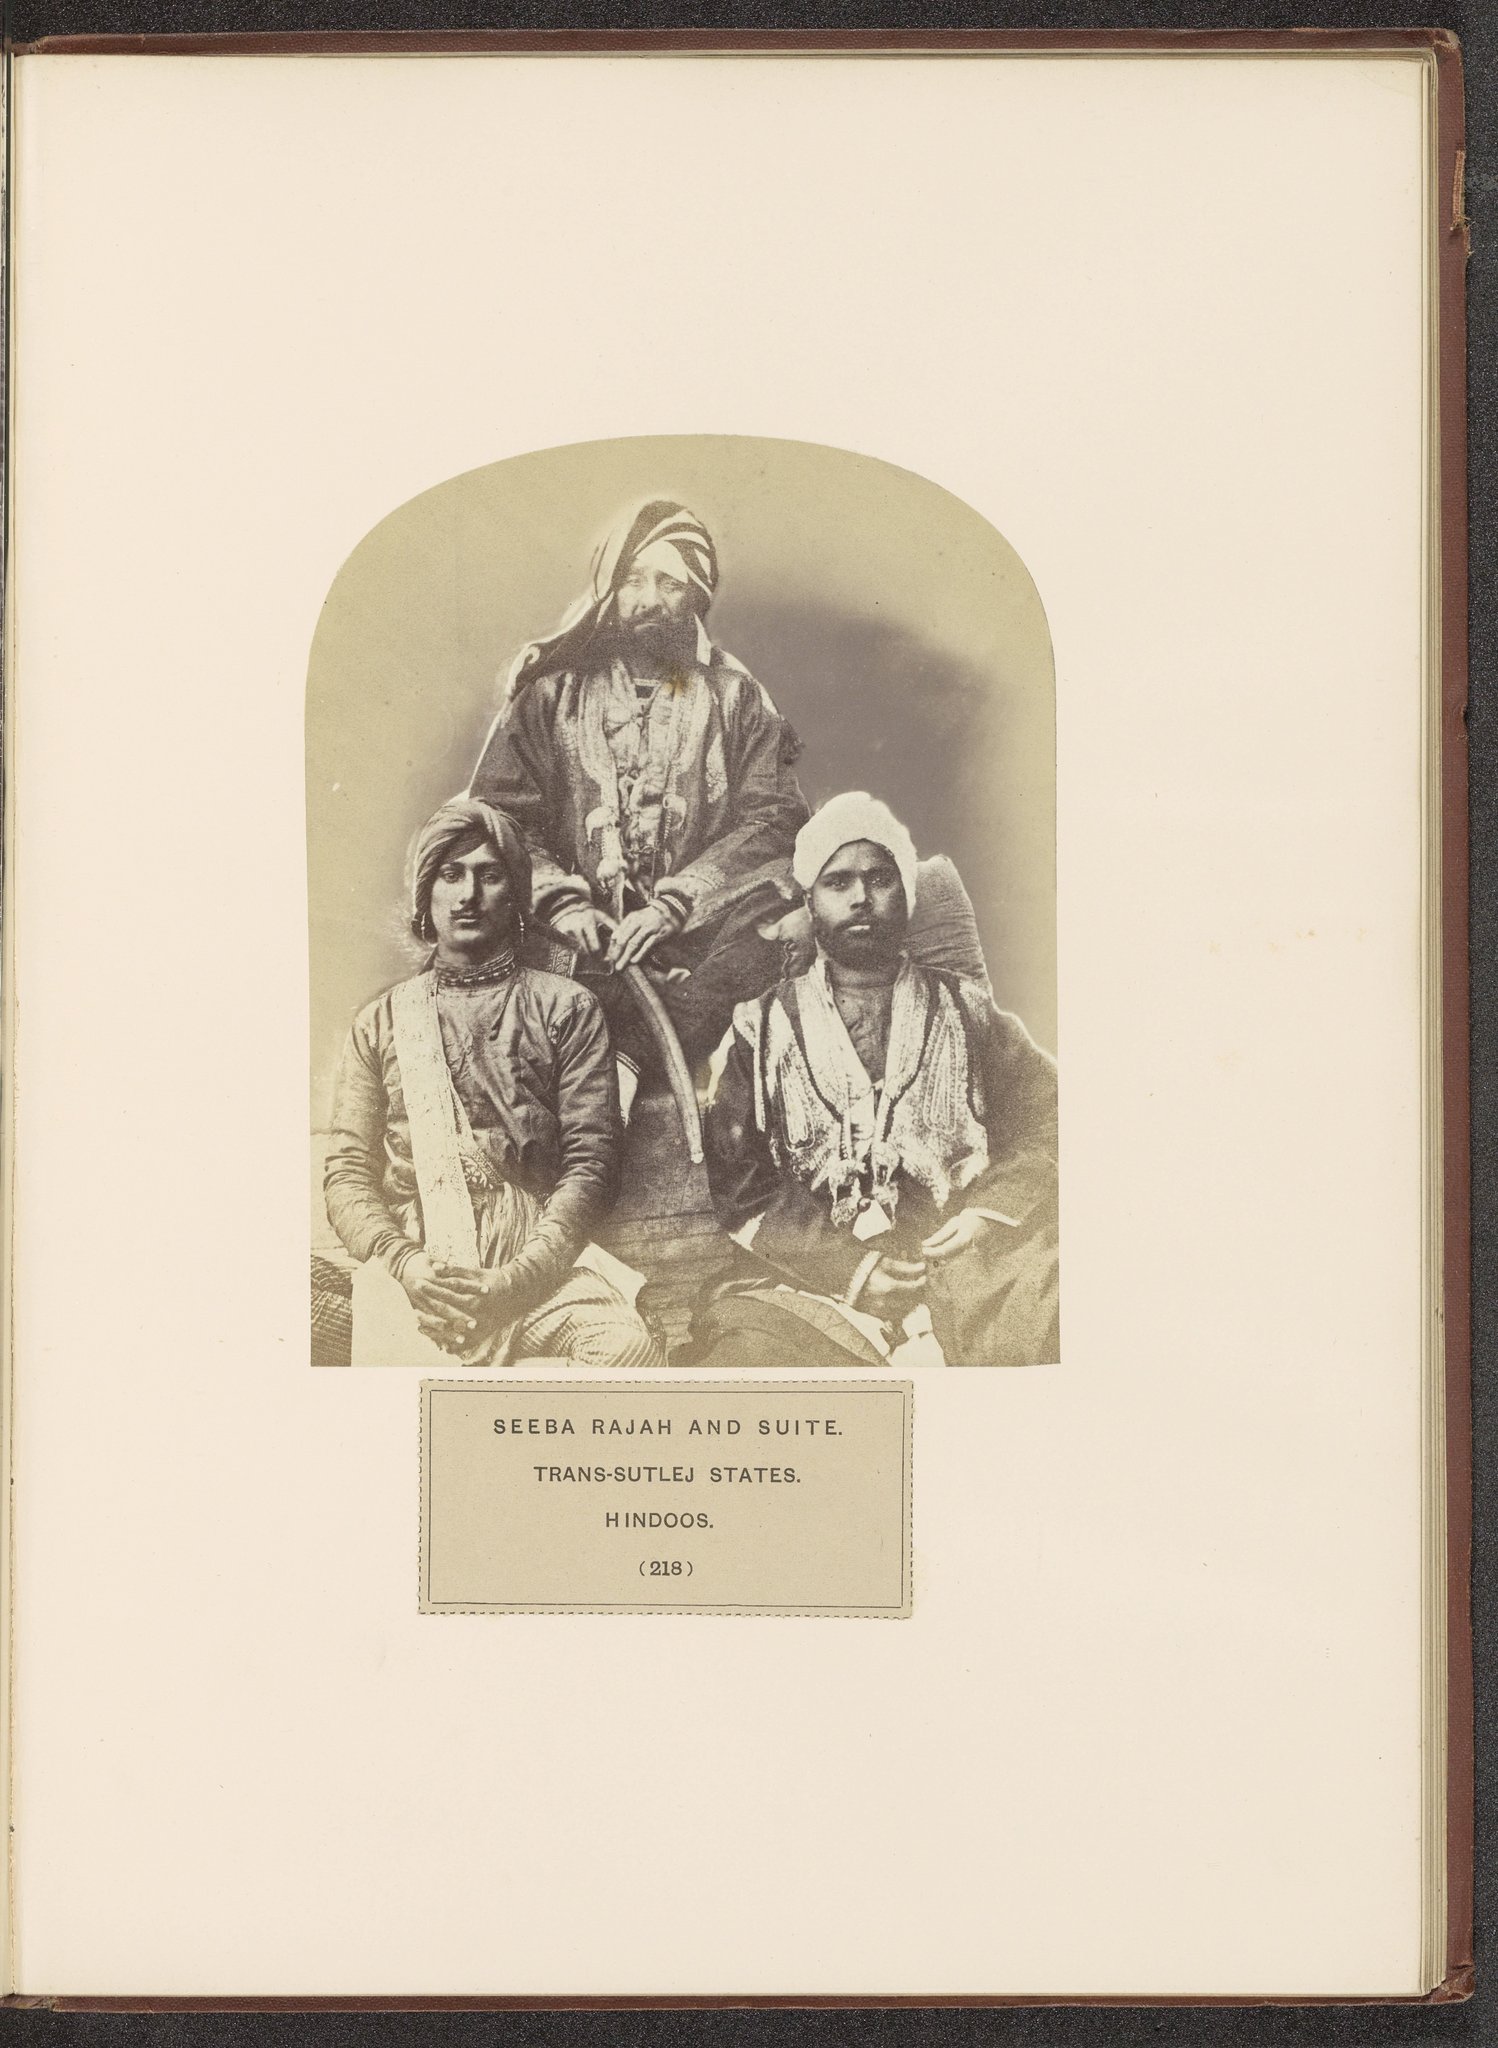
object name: photograph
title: Portrait of an raja (king) and two unknown men from Kangra, Himachal Pradesh, India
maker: Anonymous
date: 1859-1869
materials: photographic support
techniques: albumen print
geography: kangra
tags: head-gear: turban, ruler, sovereign, human races; peoples; nationalities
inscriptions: inscription: ‘SEEBA RAJAH AND SUITE./ TRANS-SUTLEJ STATES./ HINDOOS.’, number: ‘(218)’